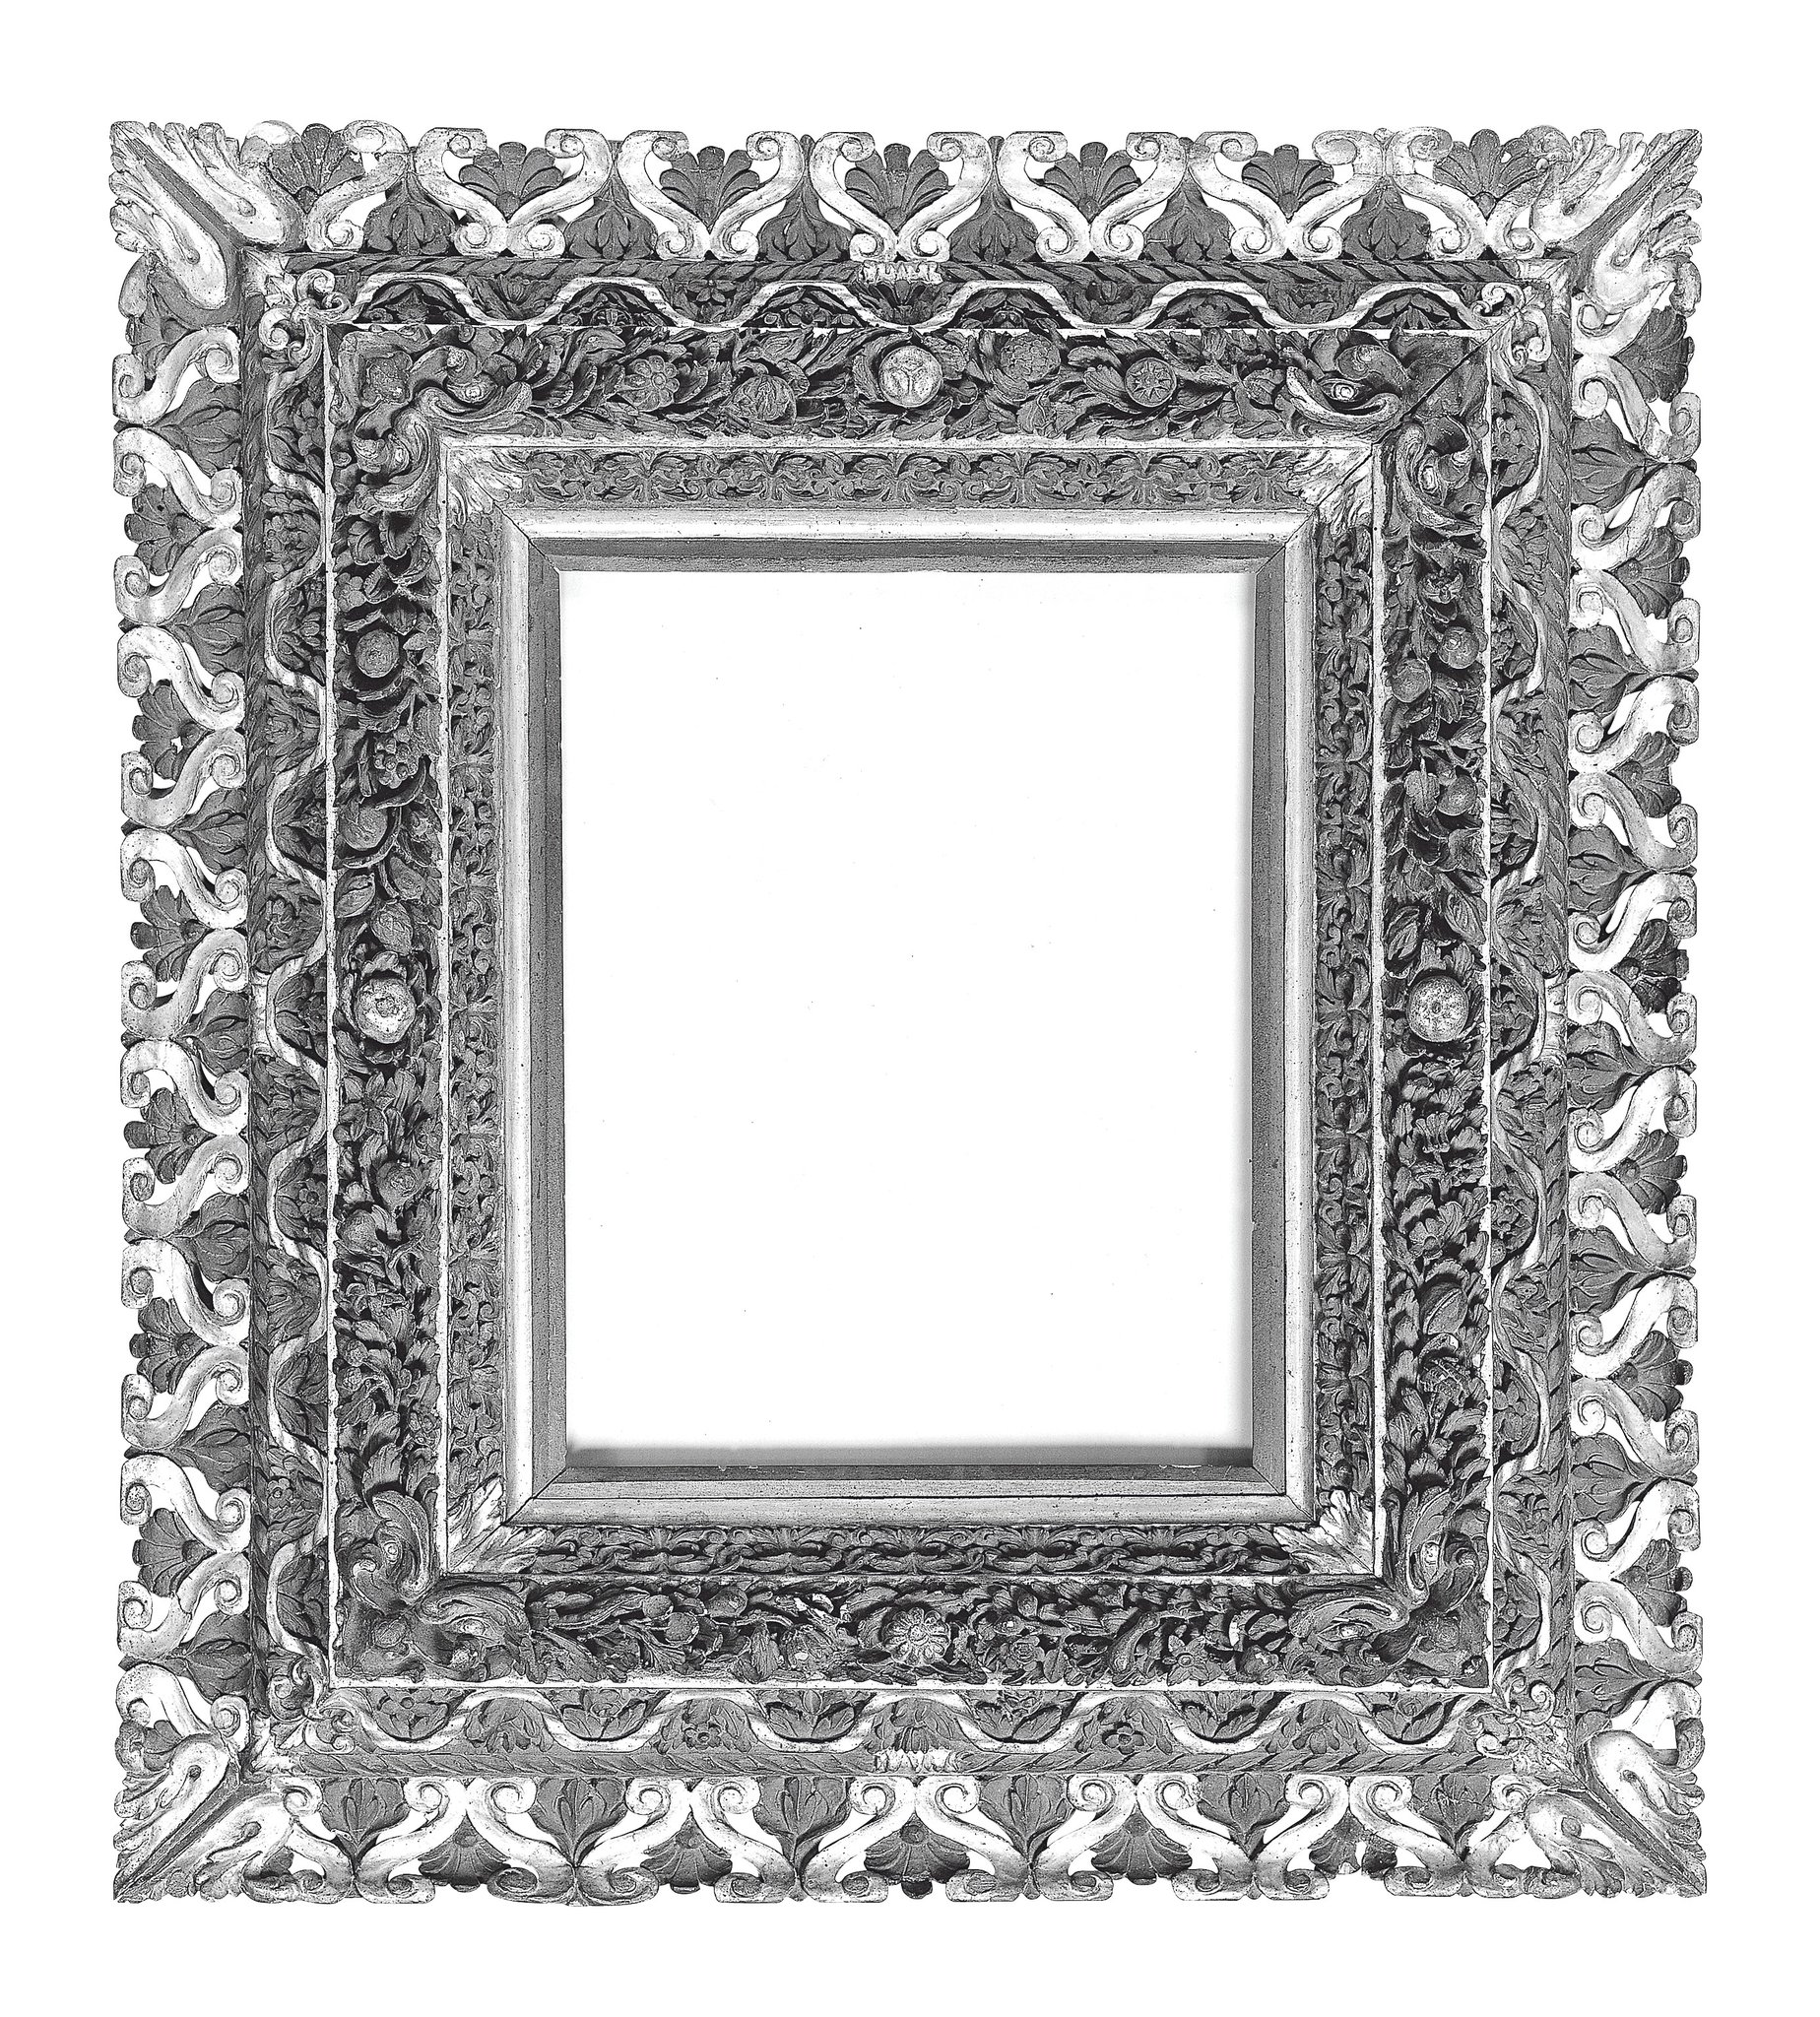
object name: frame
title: Wreath frame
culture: italian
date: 1860-1869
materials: wood